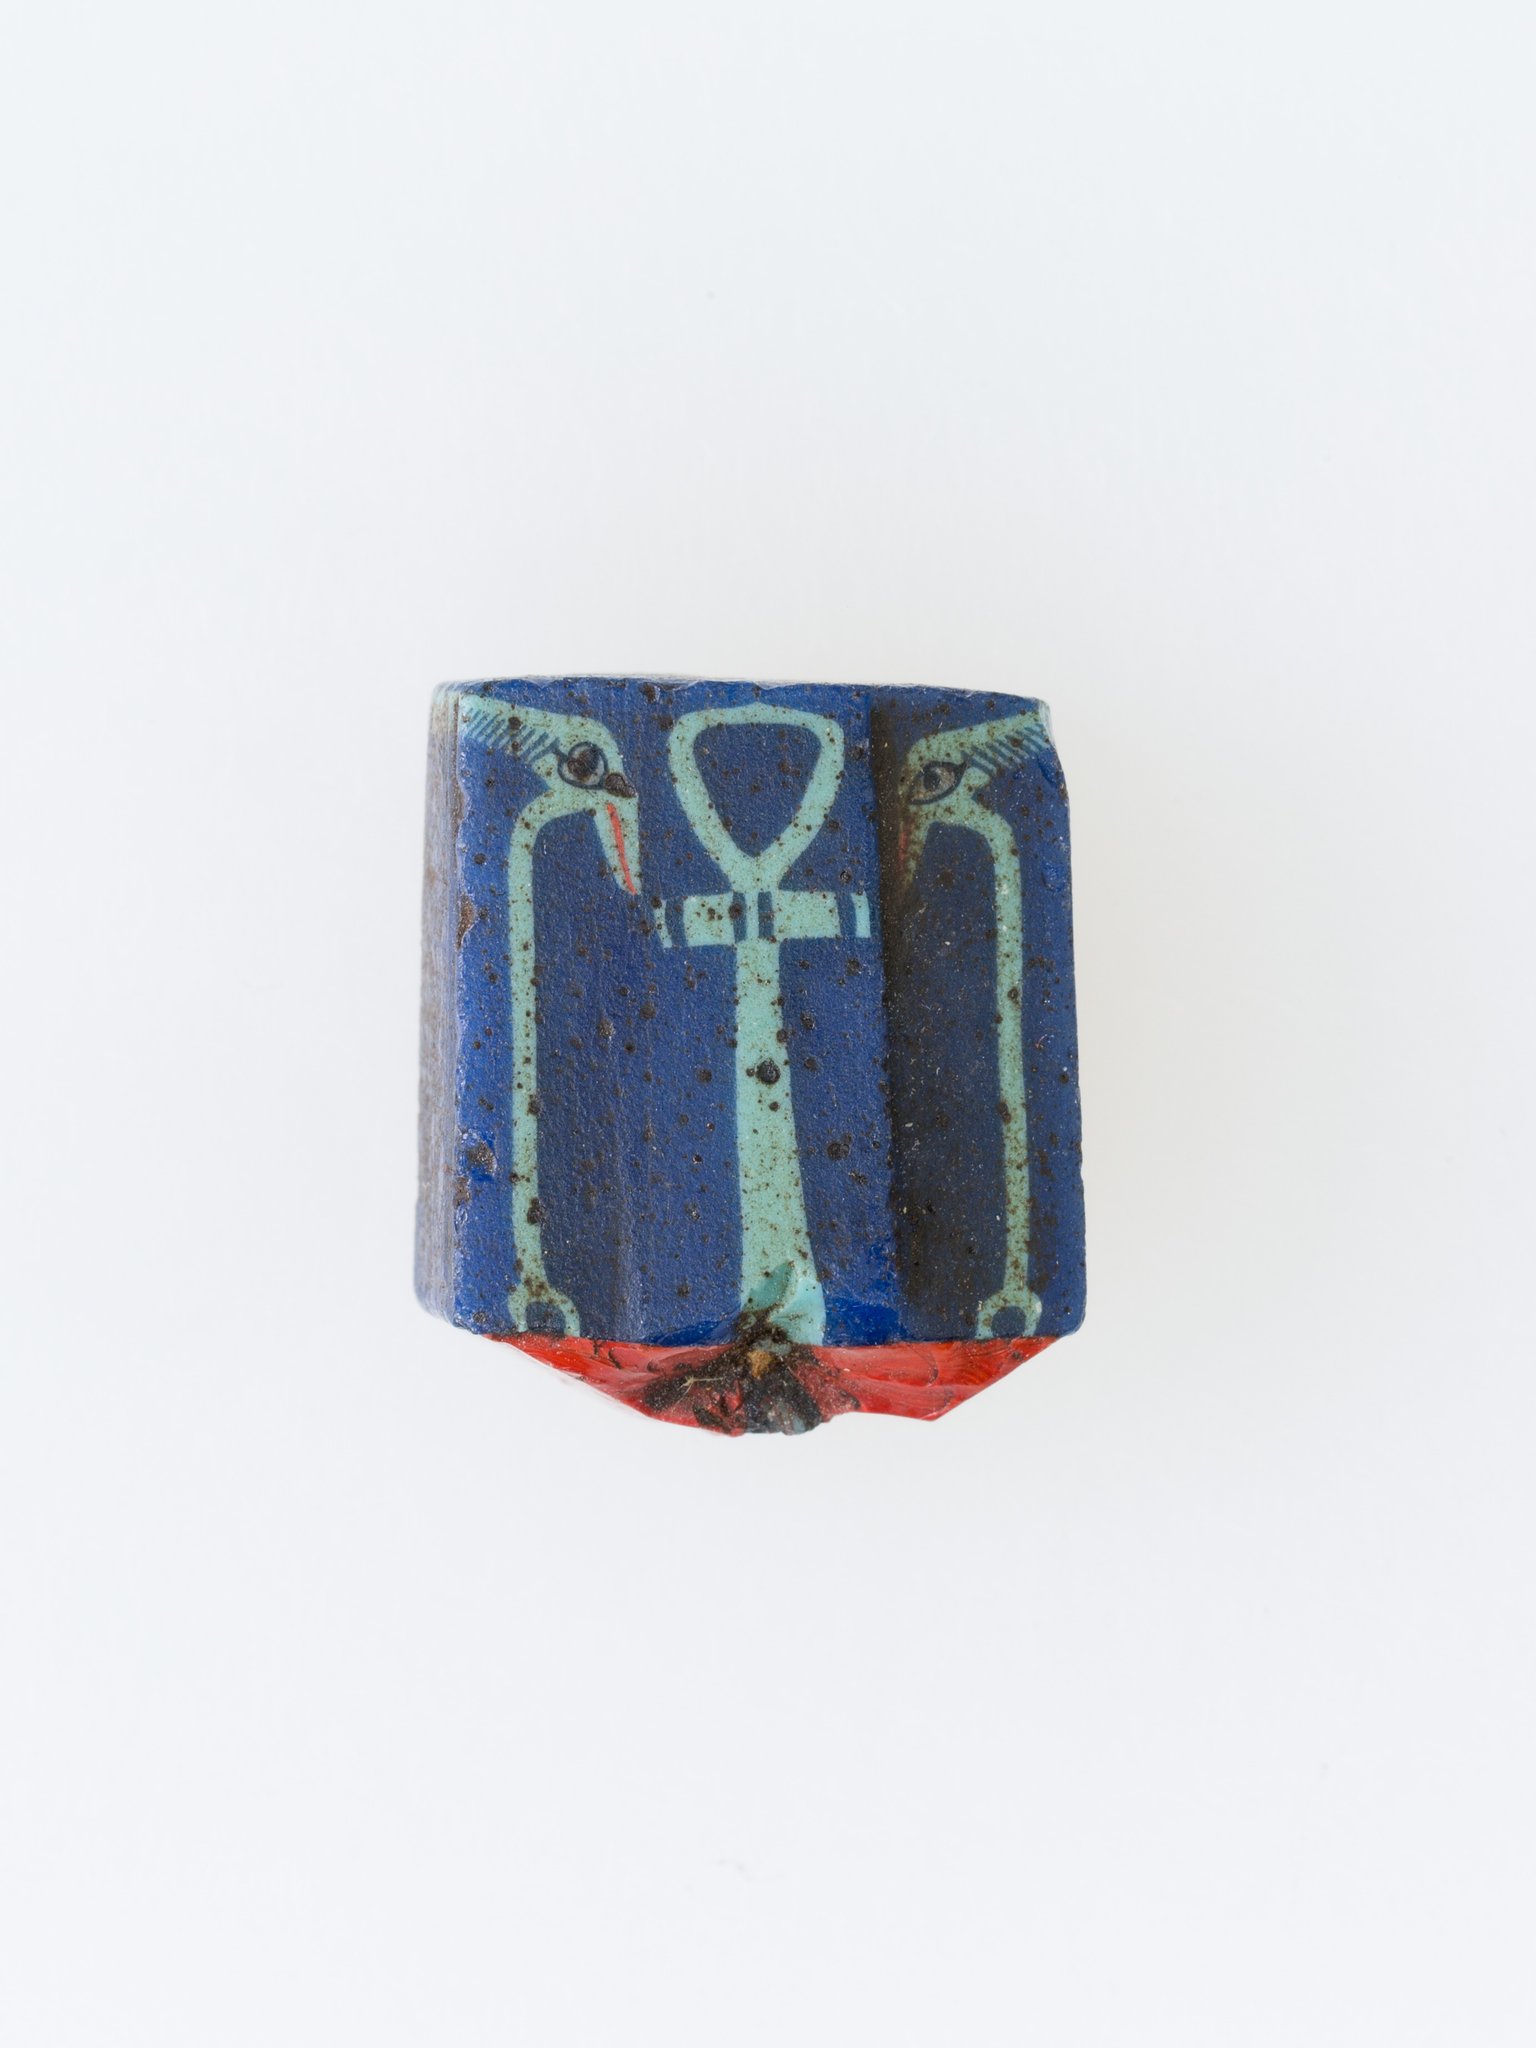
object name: inlay, ankh, wa scepter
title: Inlay, ankh, was scepters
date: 100 BCE-100 CE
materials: glass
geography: egypt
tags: ankh